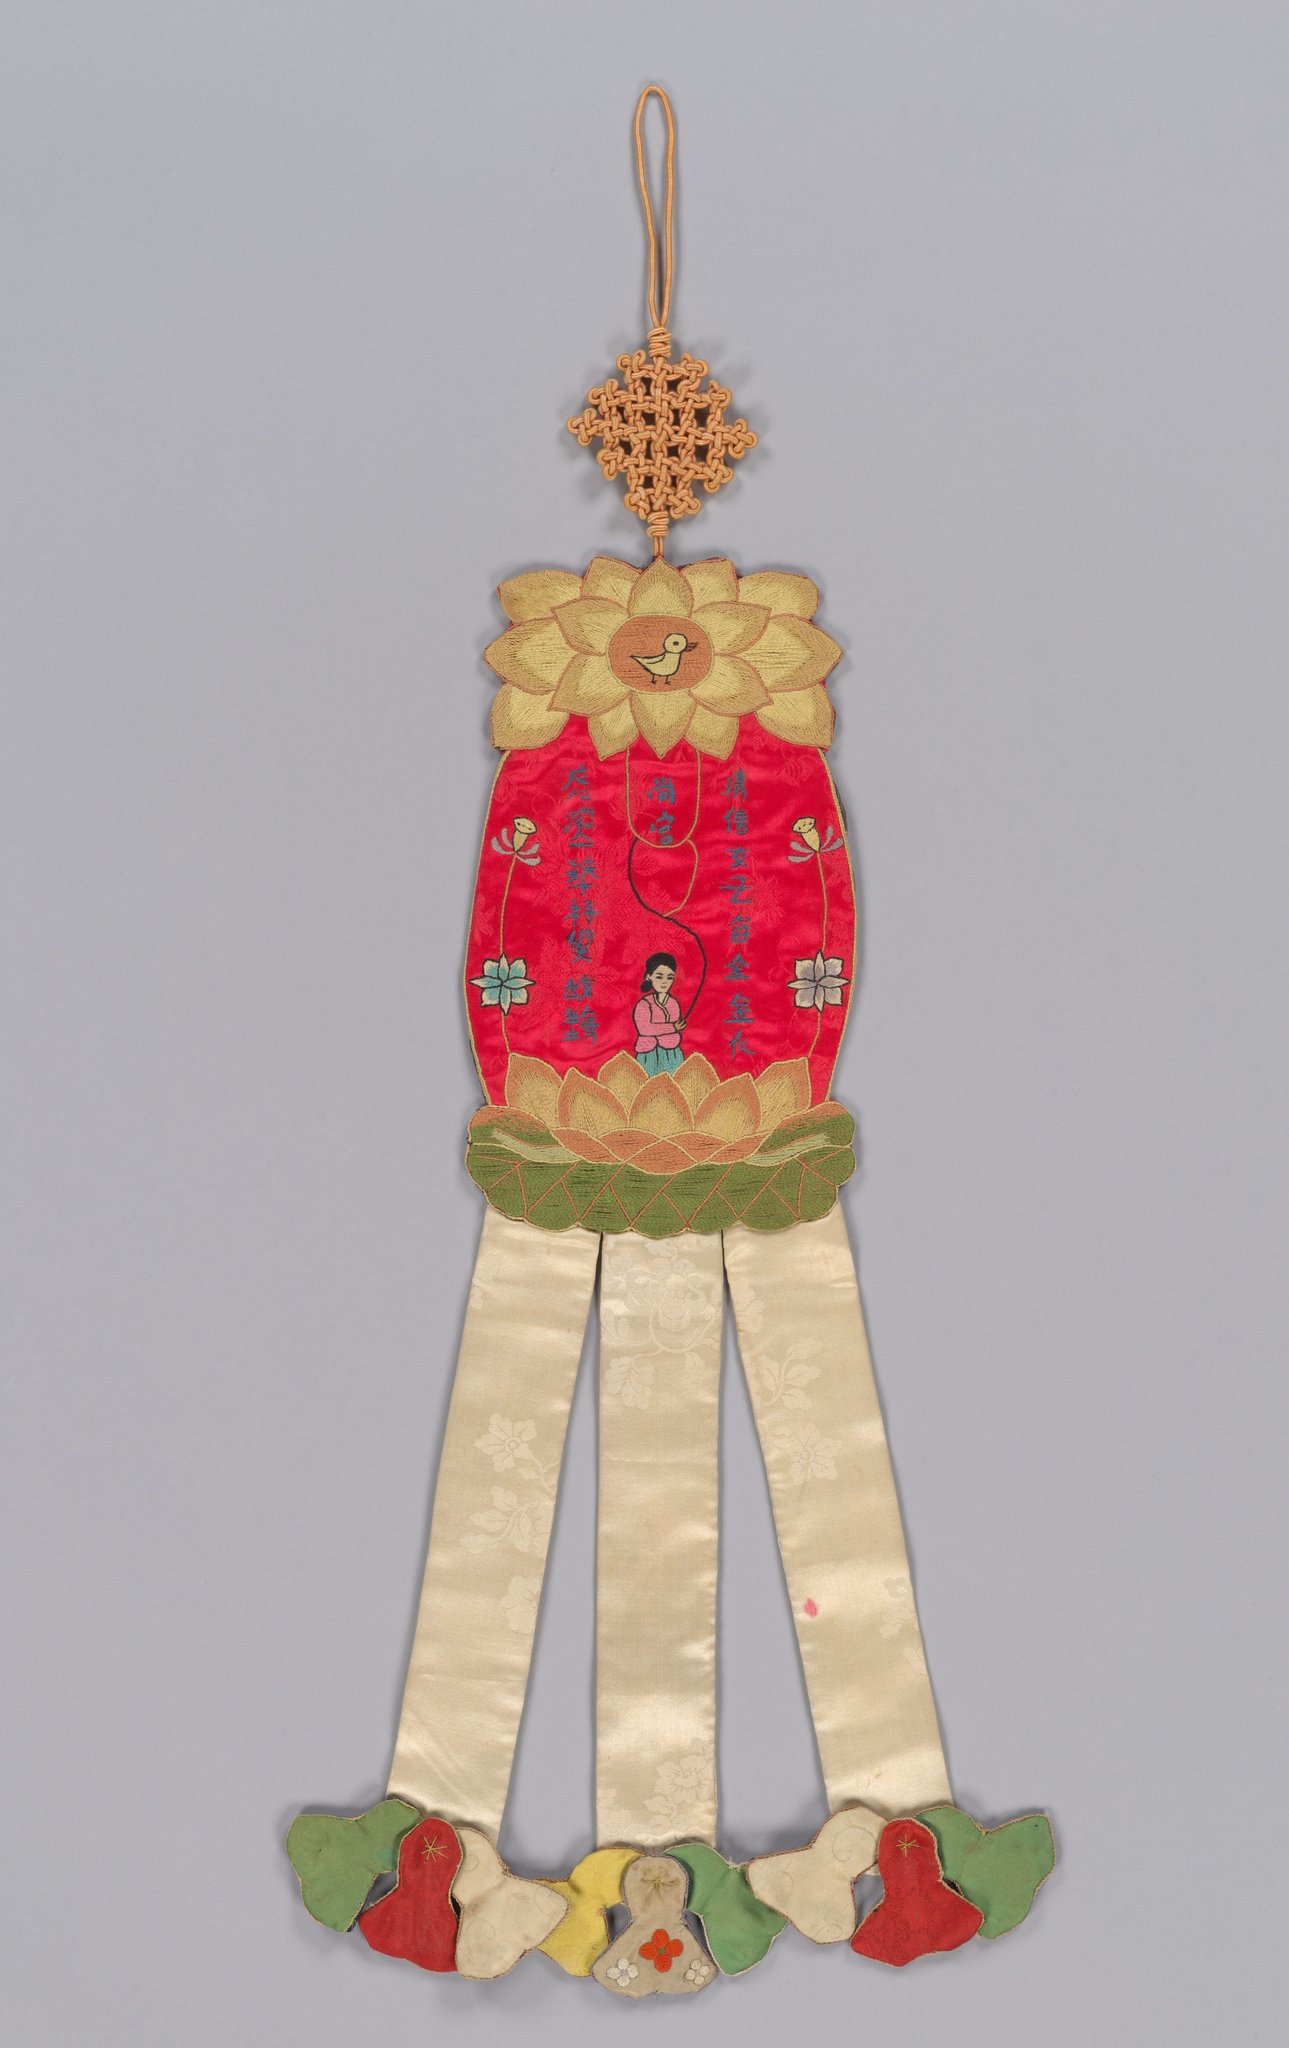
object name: pouch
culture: korean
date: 1867-1933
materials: silk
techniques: embroidery